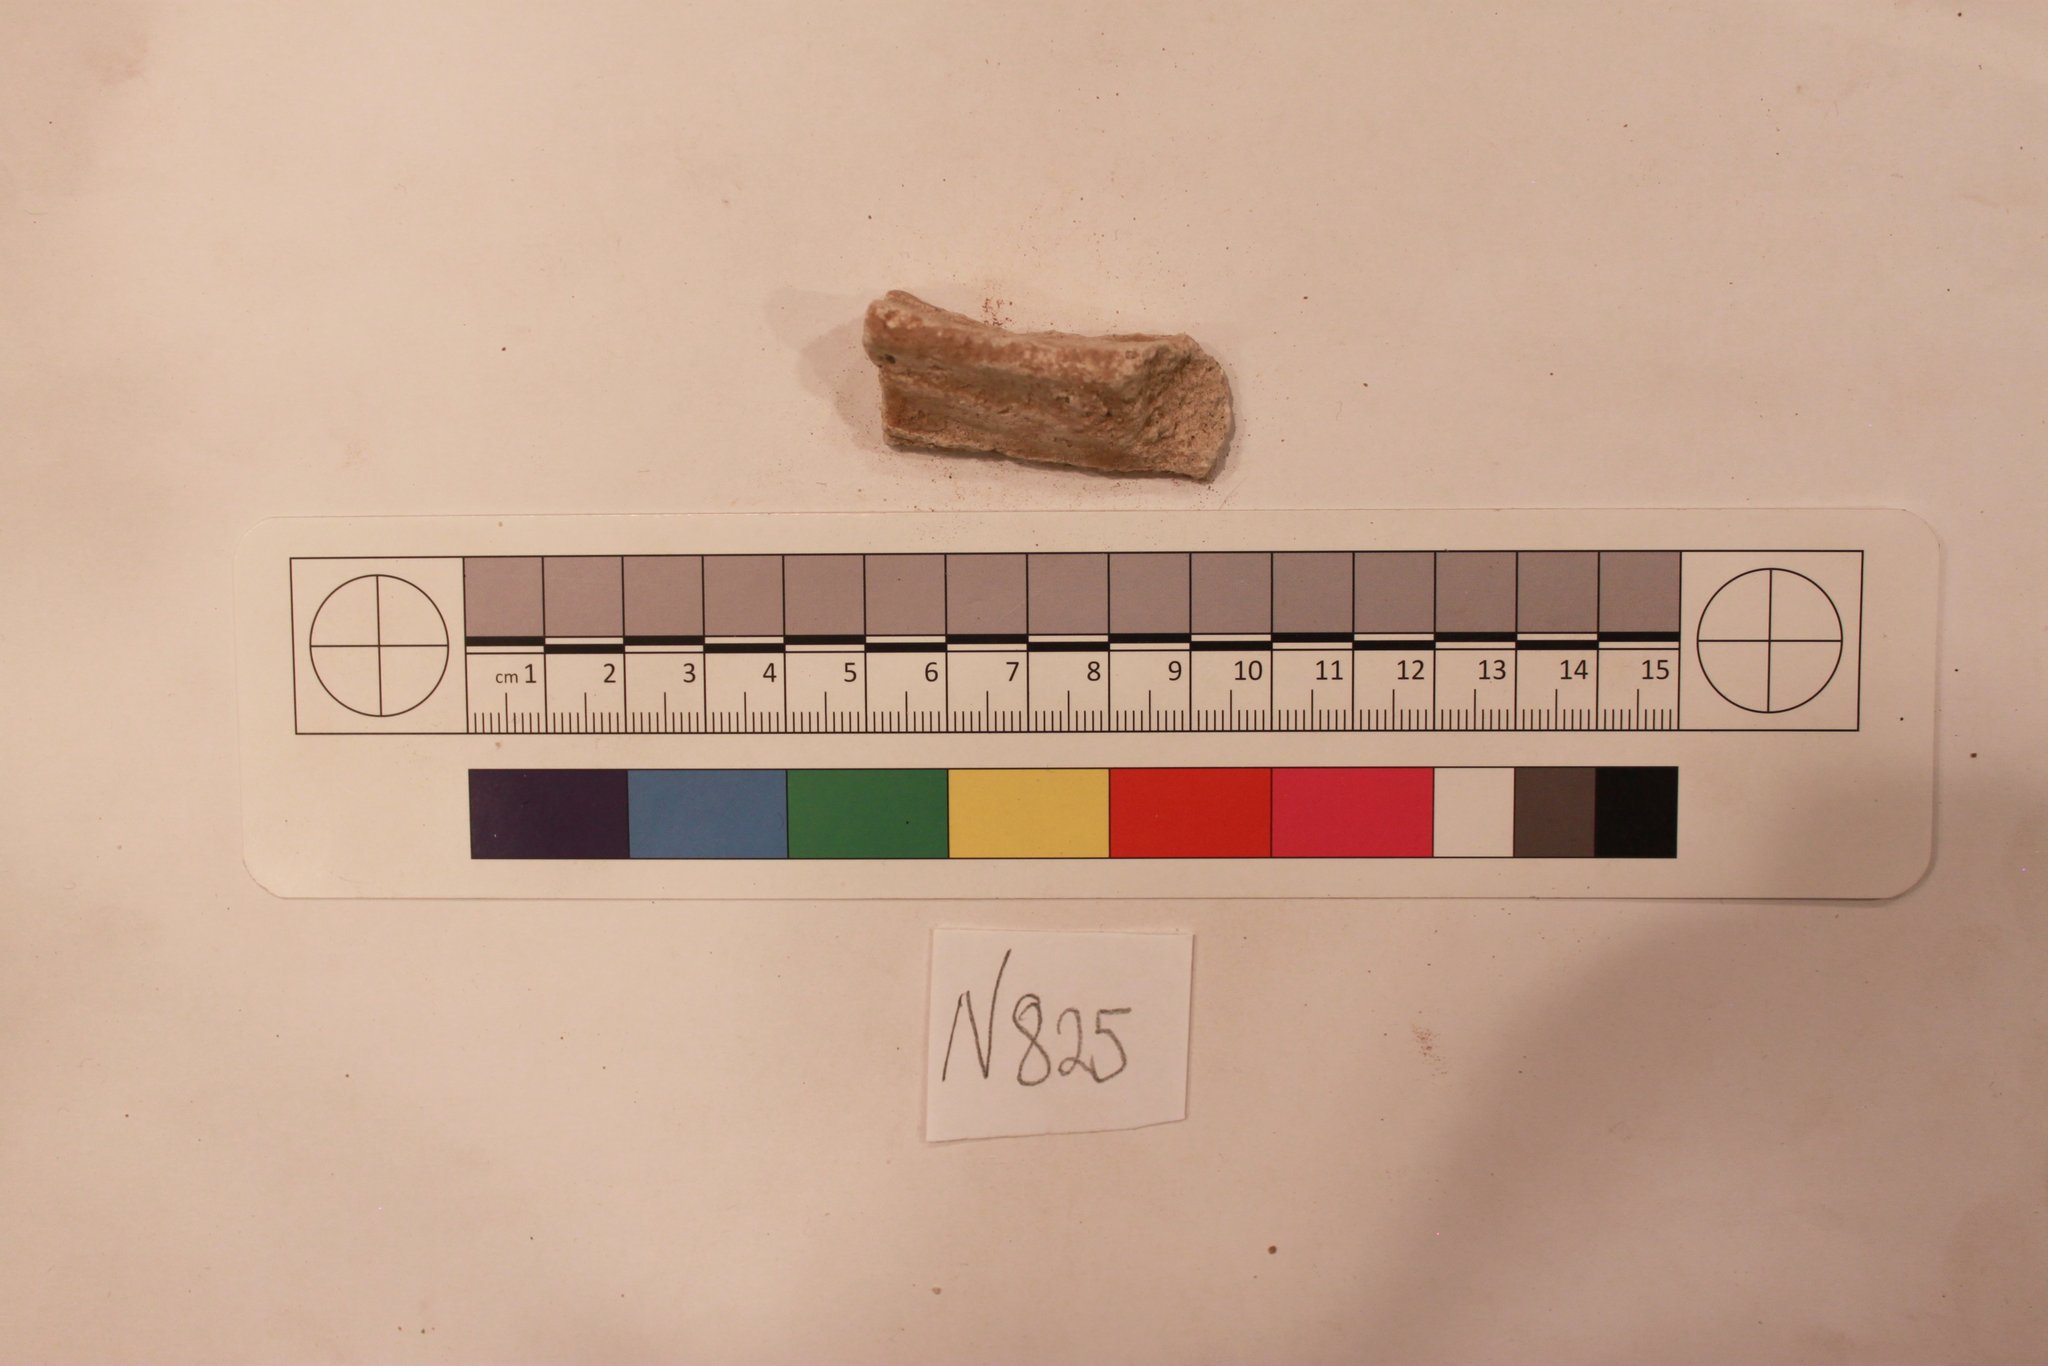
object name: fragment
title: Stucco Fragment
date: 701-1200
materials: plaster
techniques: carving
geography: iran